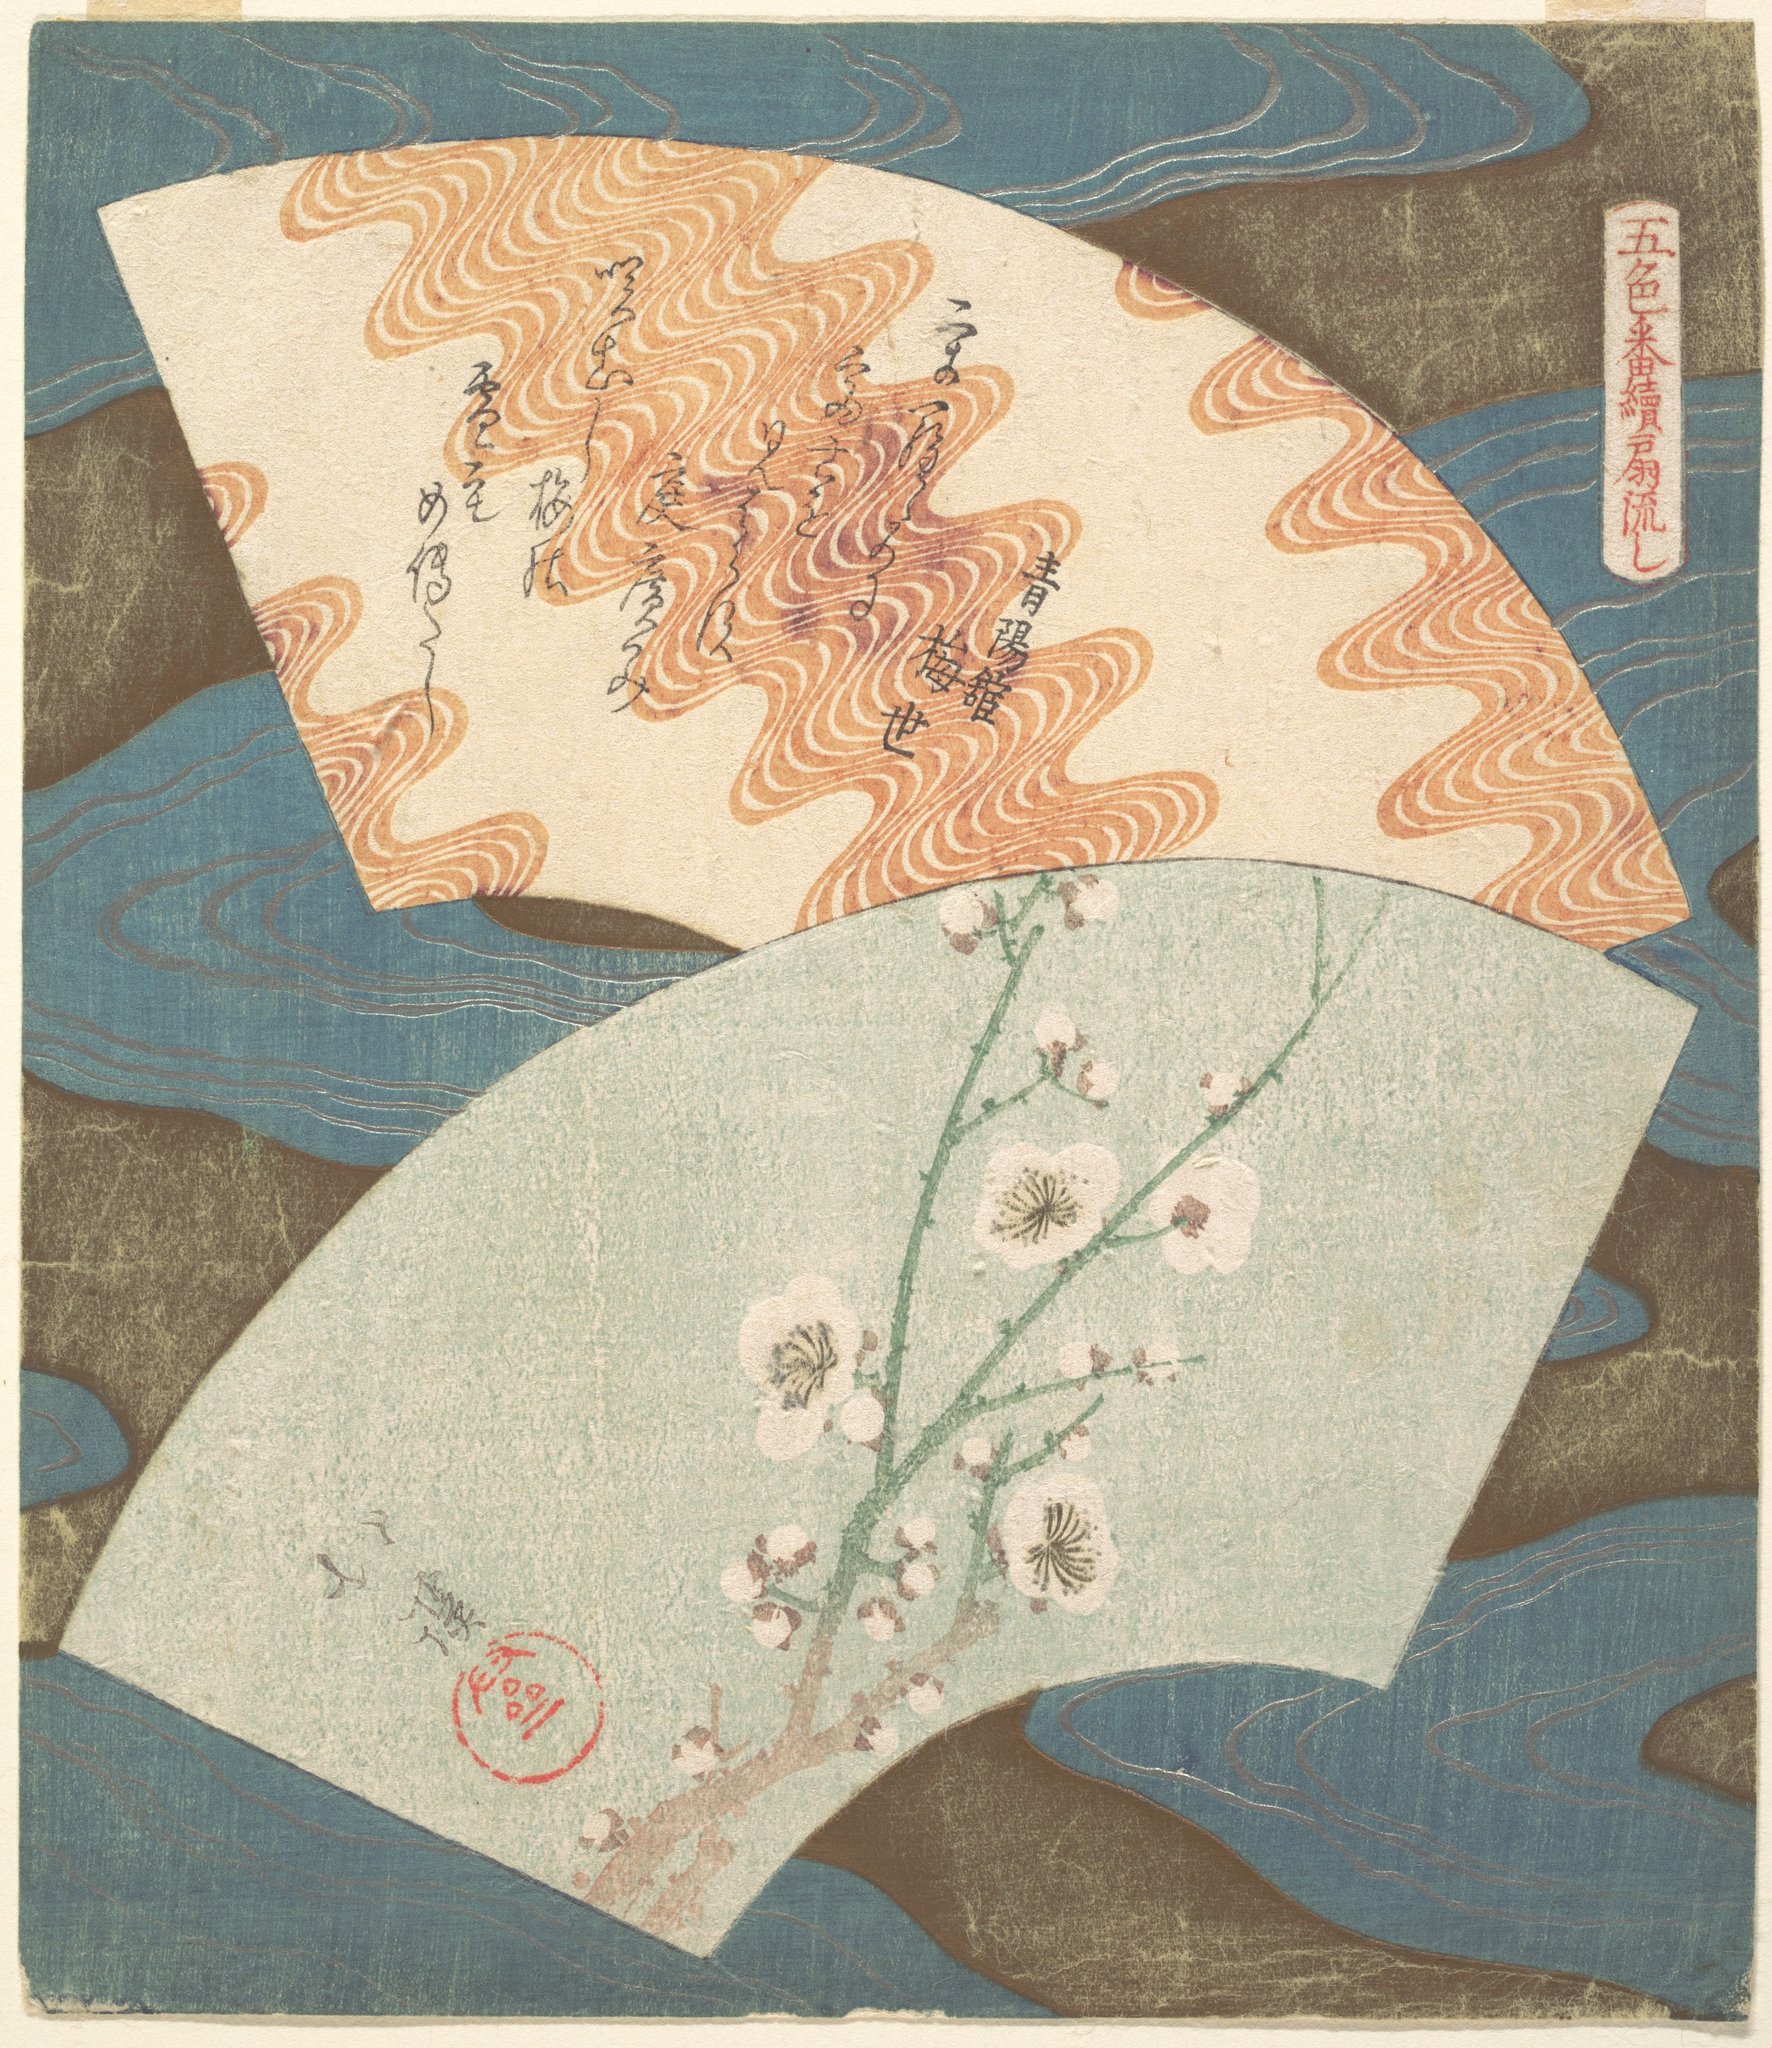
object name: print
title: Two Fan Designs: Plum Blossom and Wave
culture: japanese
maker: totoya hokkei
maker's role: artist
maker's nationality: japanese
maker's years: 1780-1850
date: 1780-1850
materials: ink, paper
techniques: surimono, woodblock print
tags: flowers